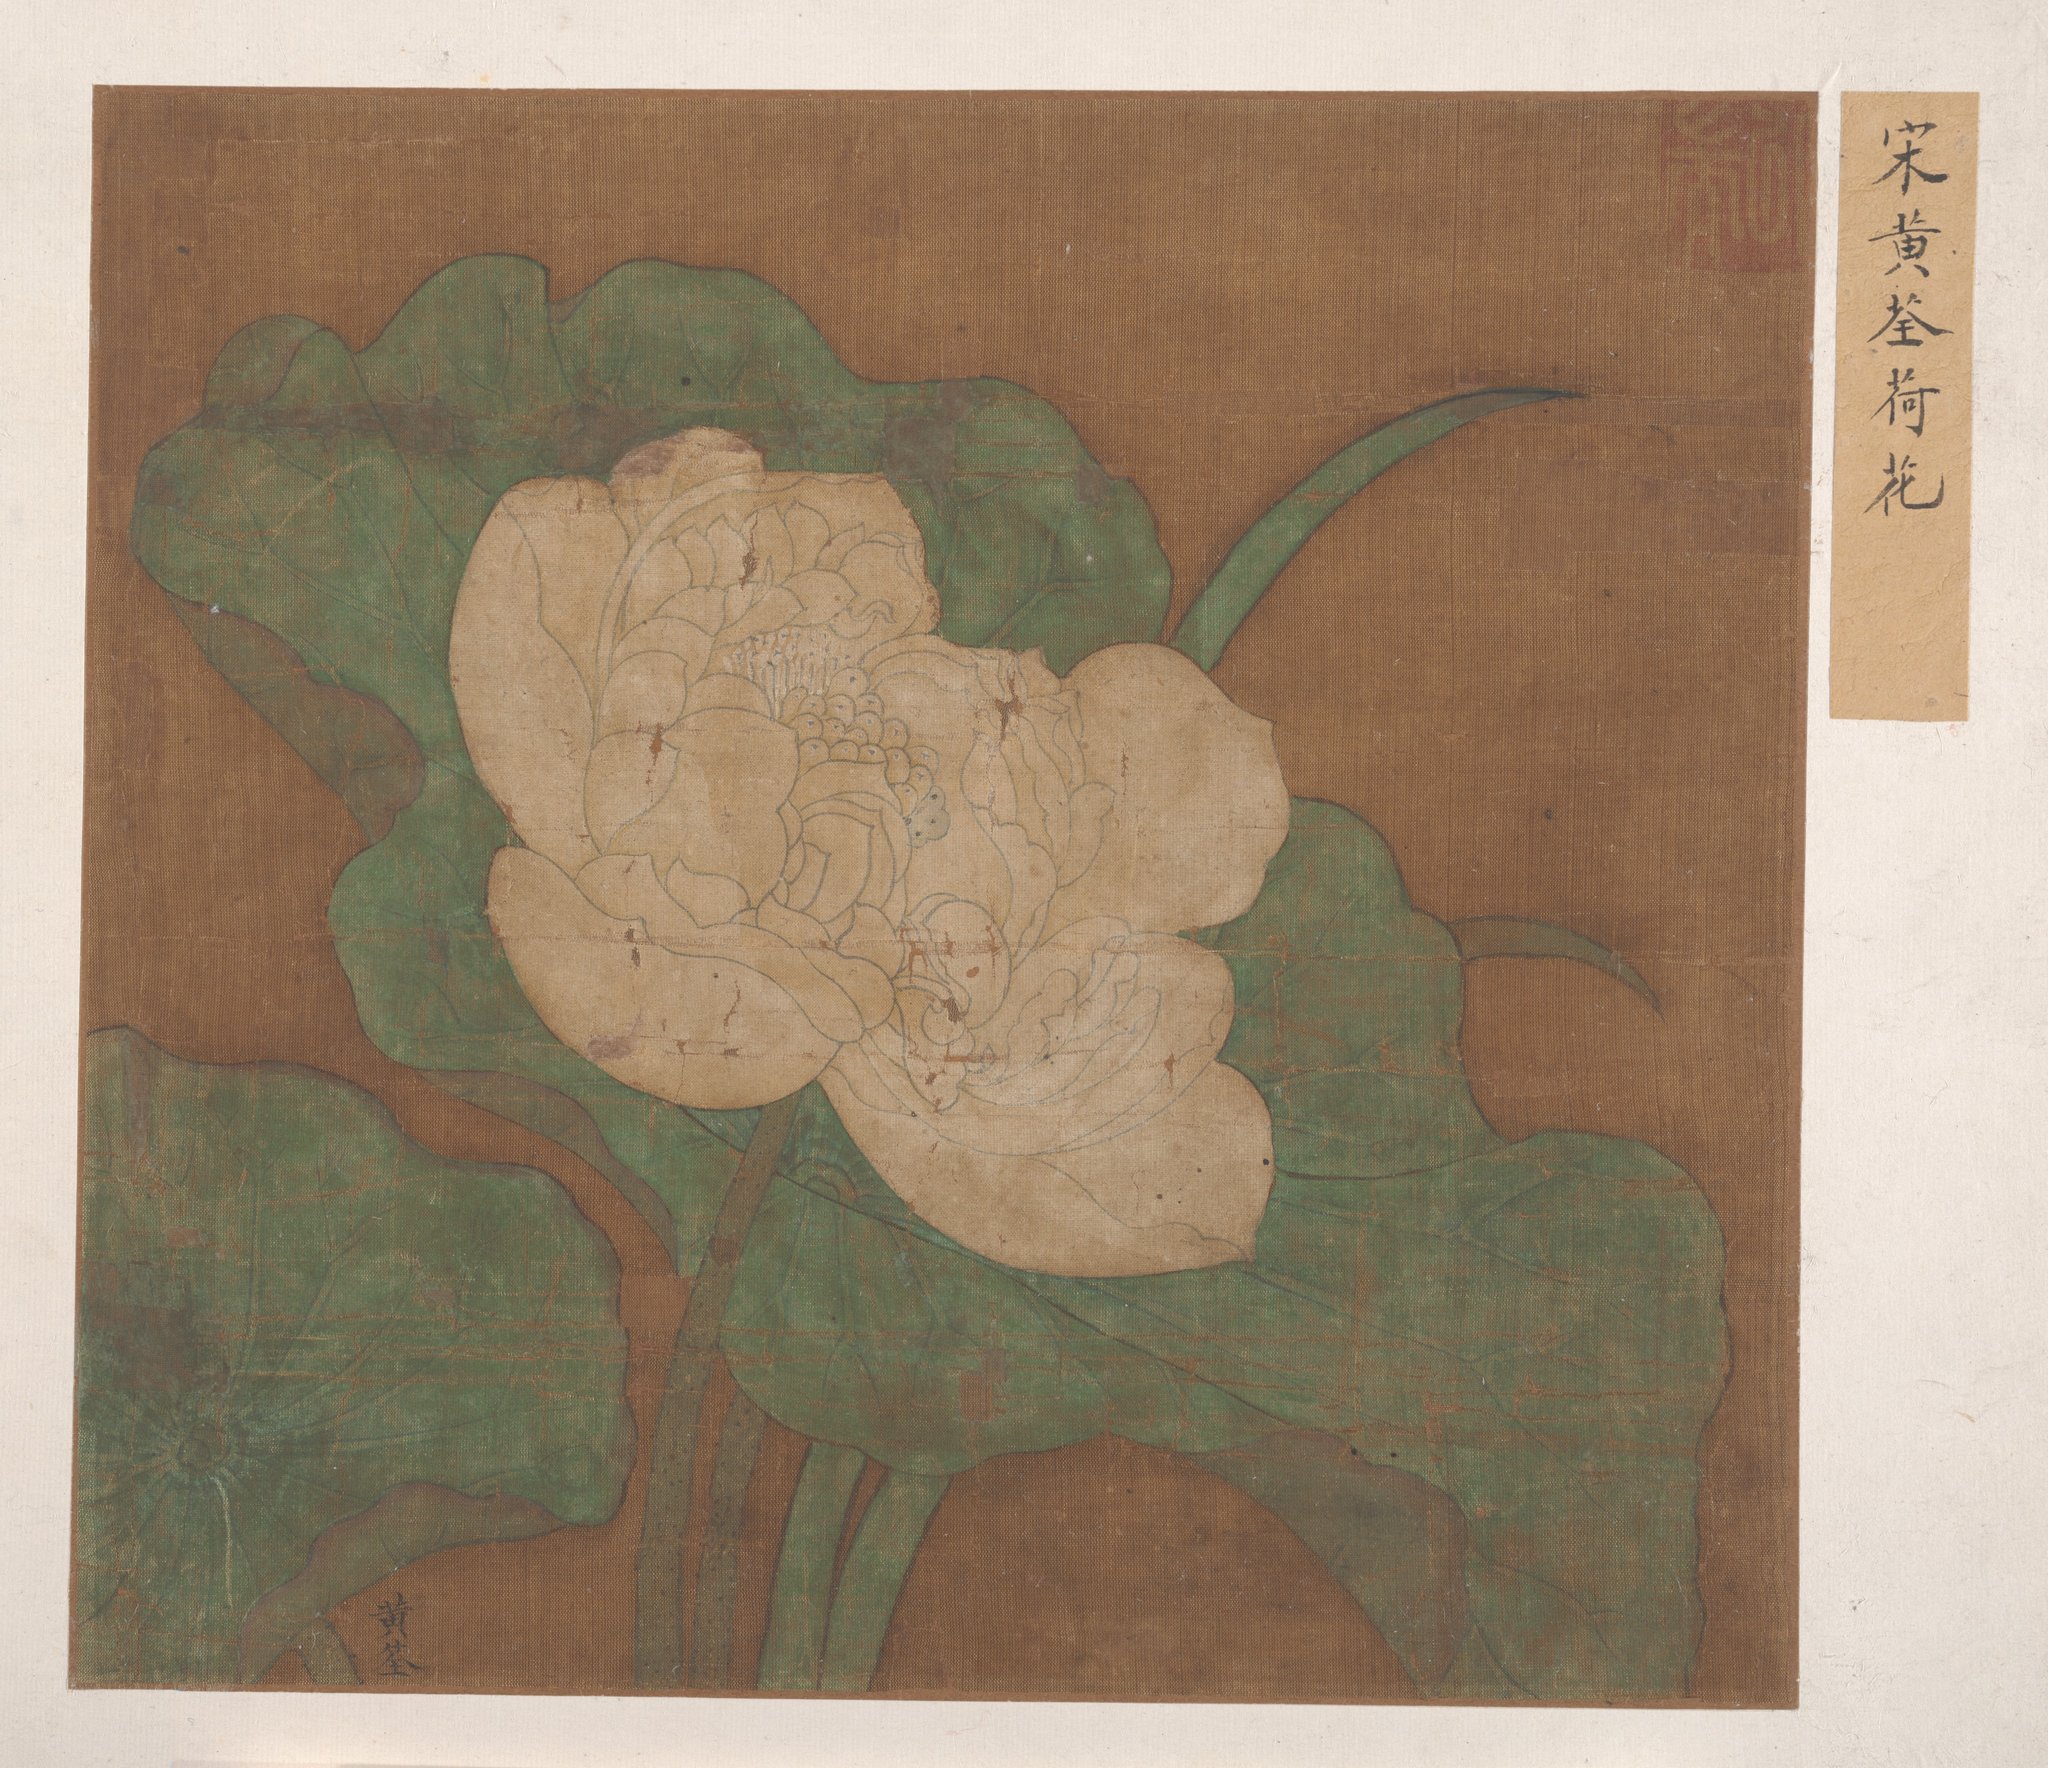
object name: album leaf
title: Lotus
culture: chinese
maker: unidentified artist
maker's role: artist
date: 1368-1644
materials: ink, silk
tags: lotuses